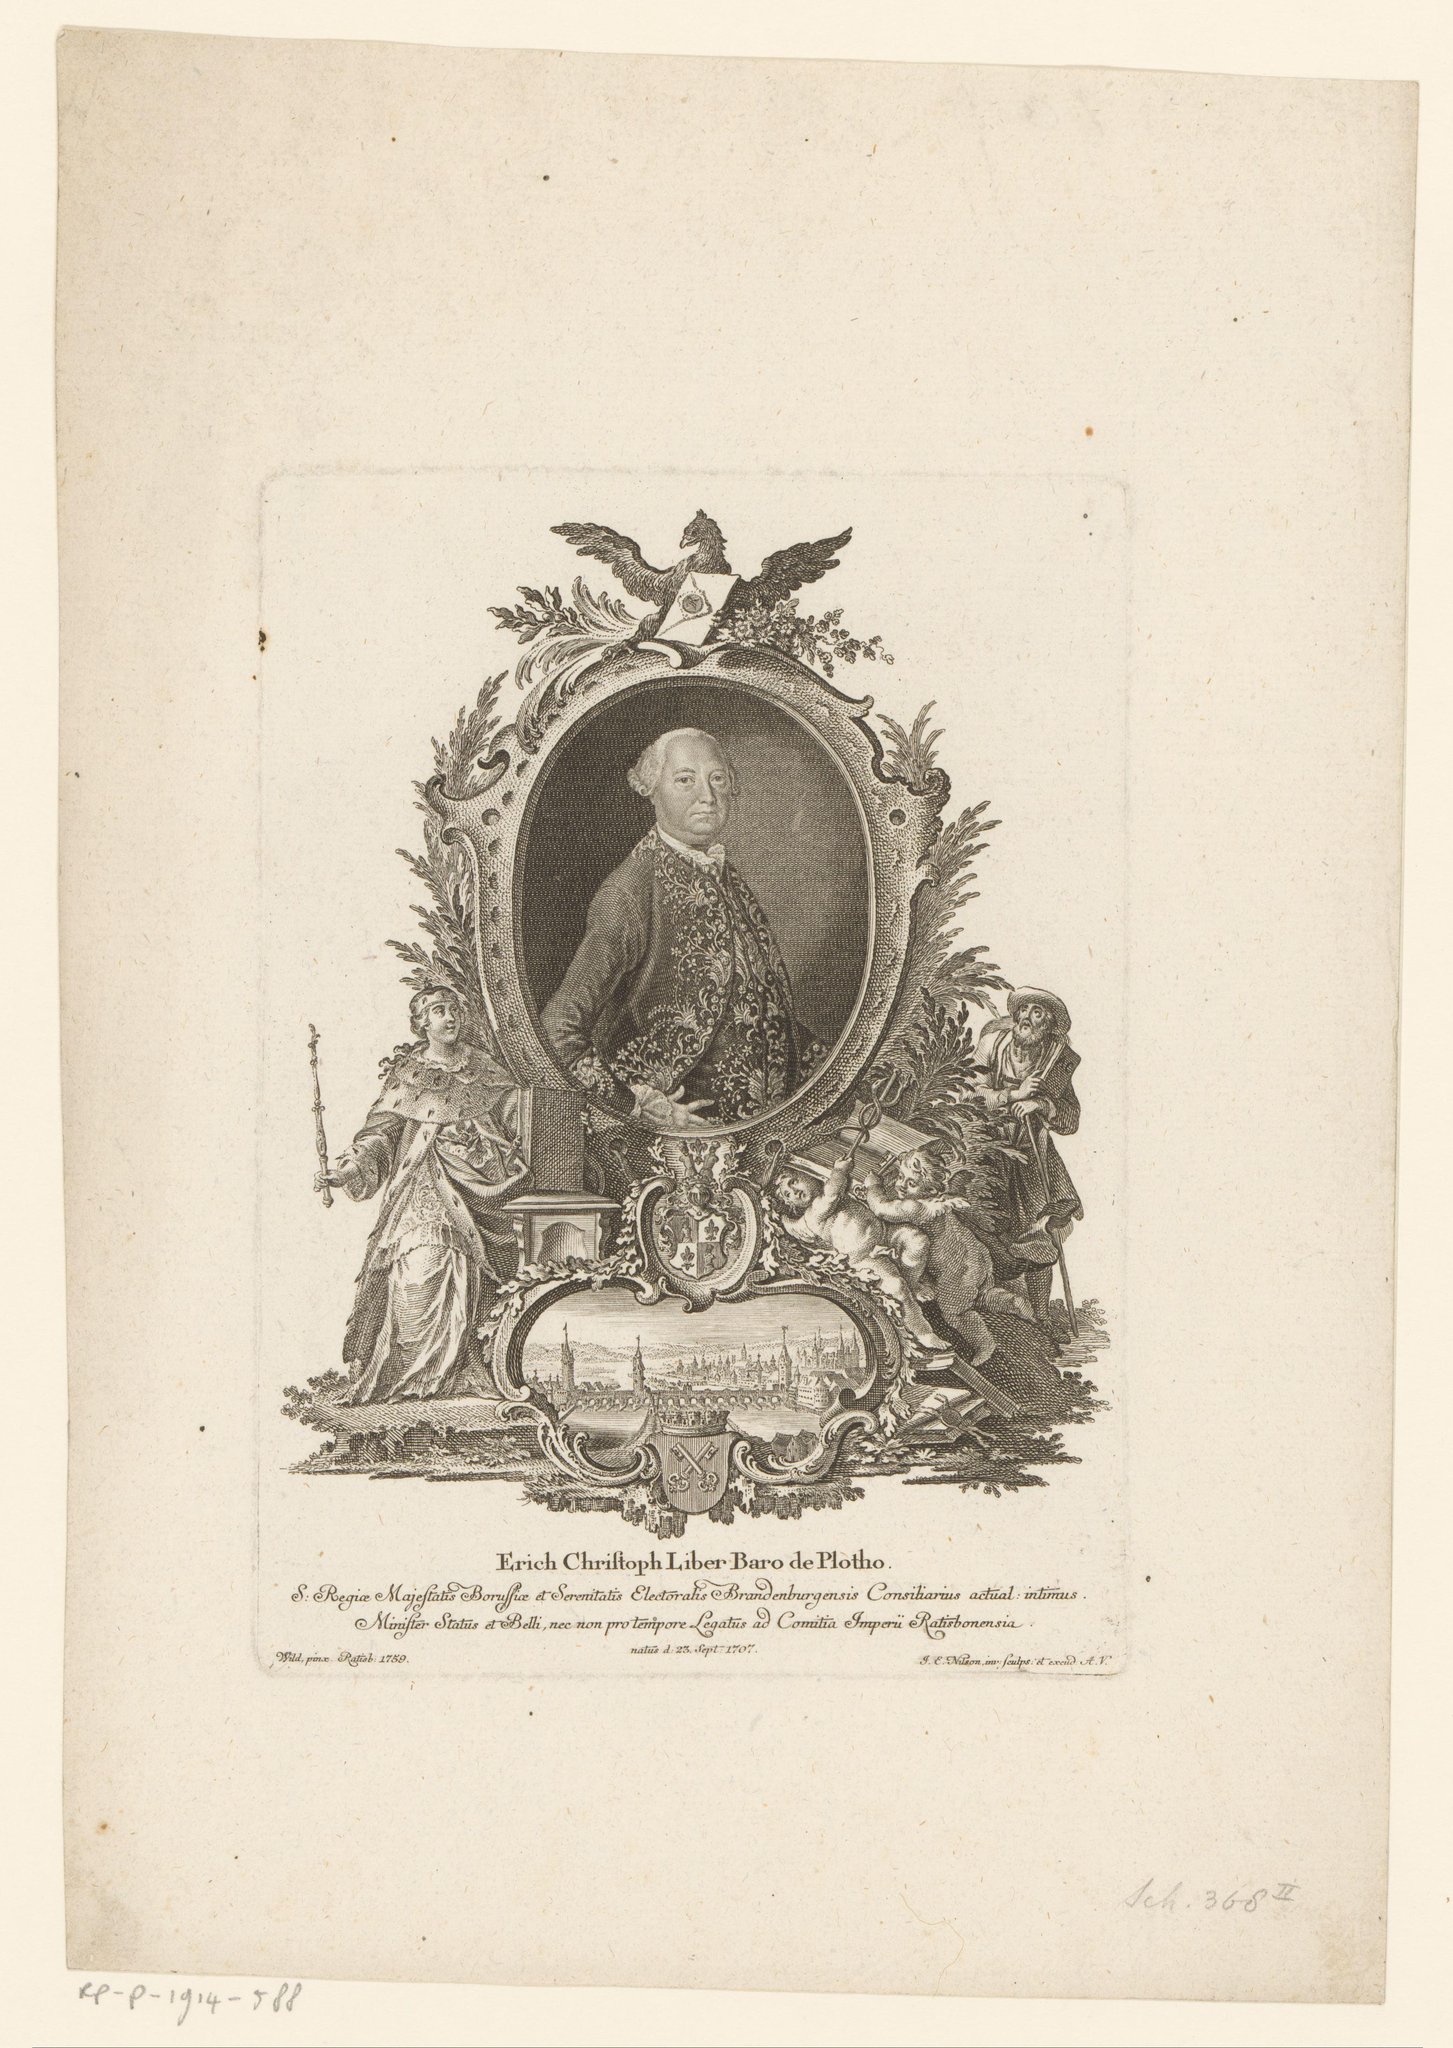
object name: print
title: Portret van Erich Christoph von Plotho, met gezicht op Regensburg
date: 1759-1788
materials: paper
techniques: engraving, etching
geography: augsburg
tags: germany, 'confessio augustana', 'augsburger konfession', historical persons, letter, envelope, caduceus (staff with two snakes, attribute of mercury), baton of general, insignia and symbols of sovereignty (crown, diadem, sceptre, orb, seal, standard, cloak, pectoral)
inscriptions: collector's mark: Lugt 2228